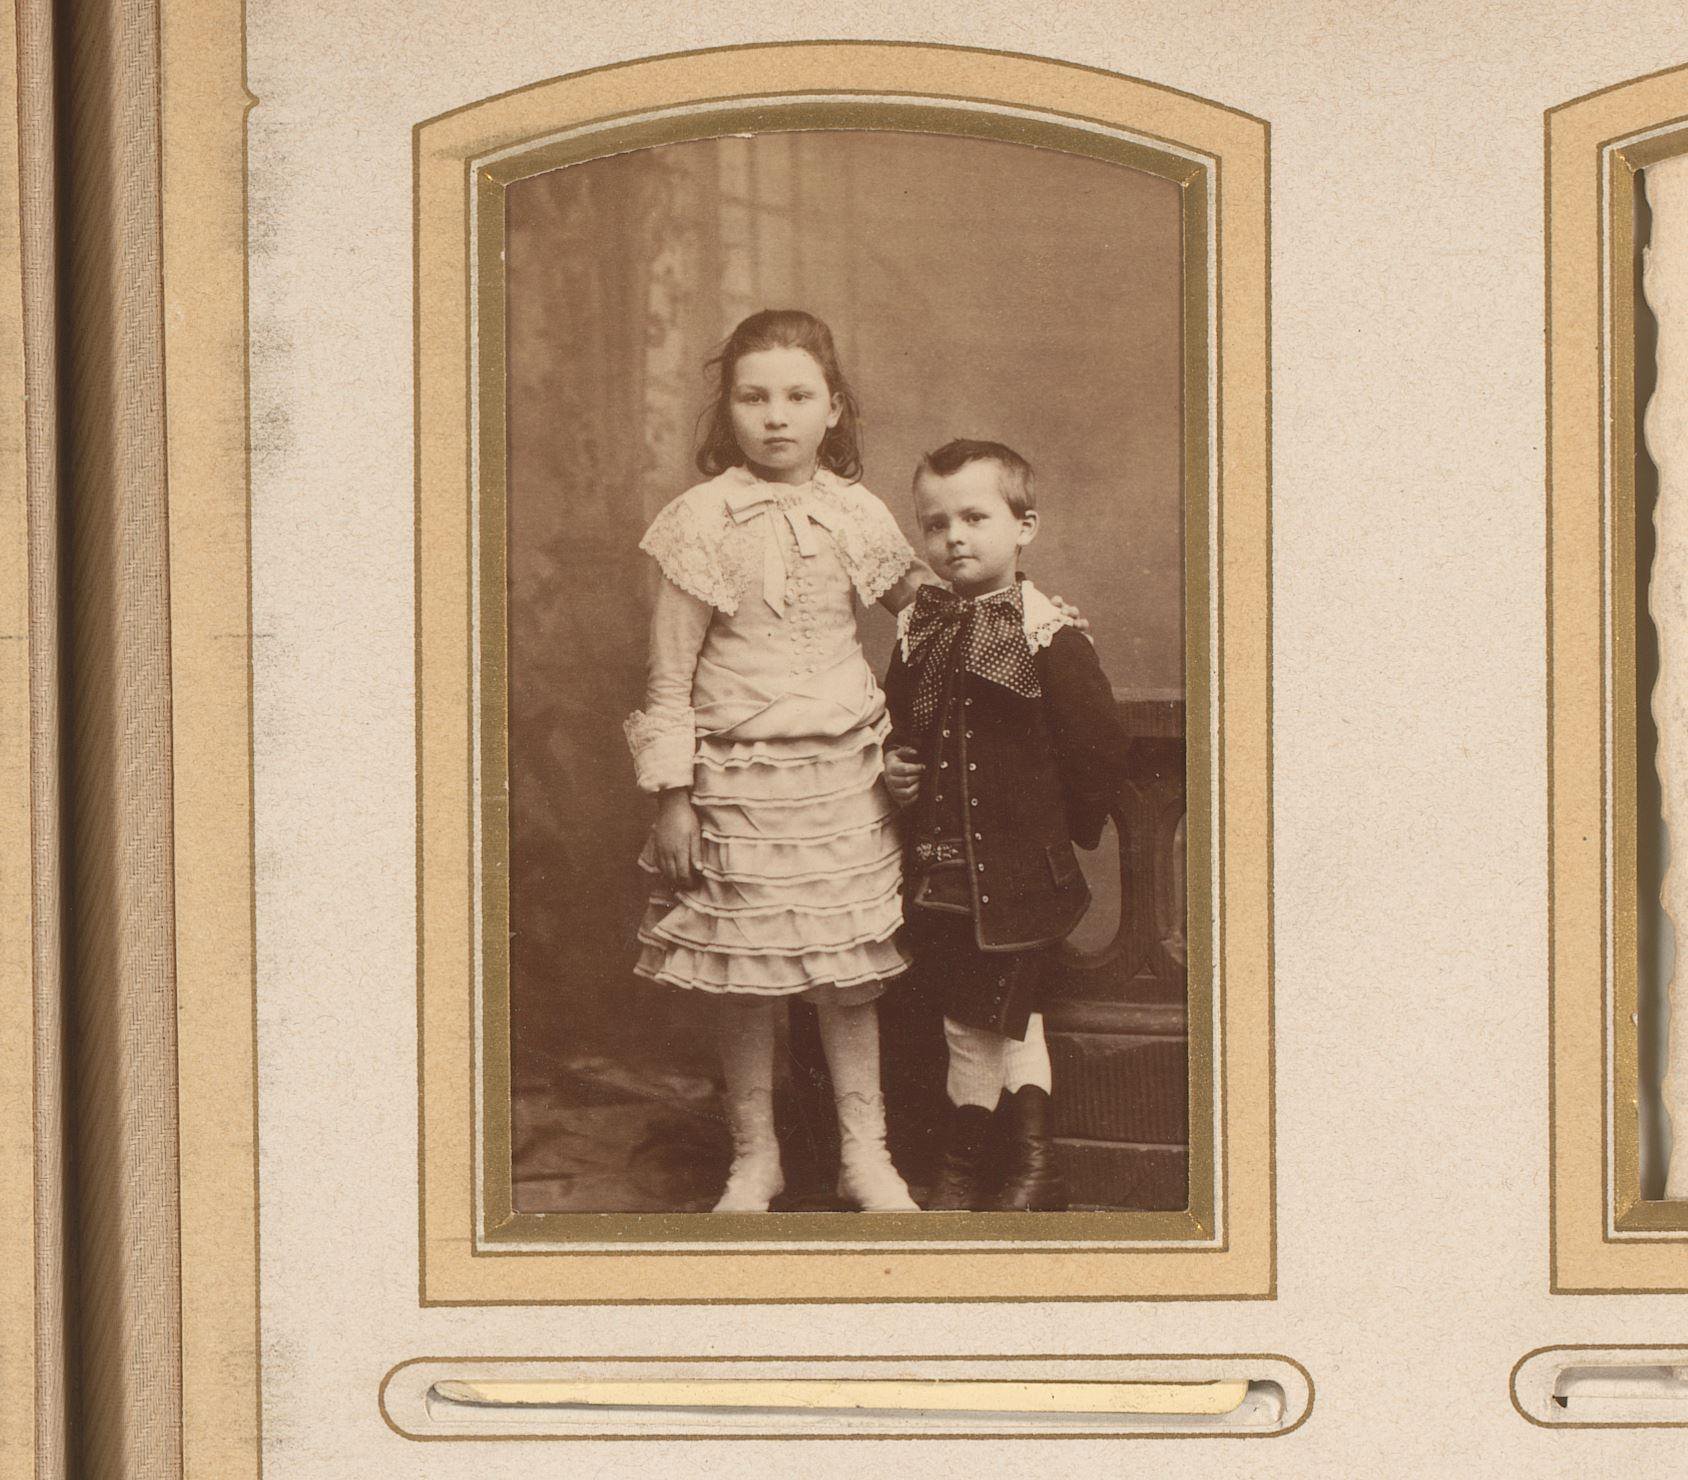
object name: album leaf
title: Portret van een meisje en een jongen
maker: Anonymous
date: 1870-1900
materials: cardboard, photographic support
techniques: albumen print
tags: boy (child between toddler and youth), historical persons, girl (child between toddler and youth)